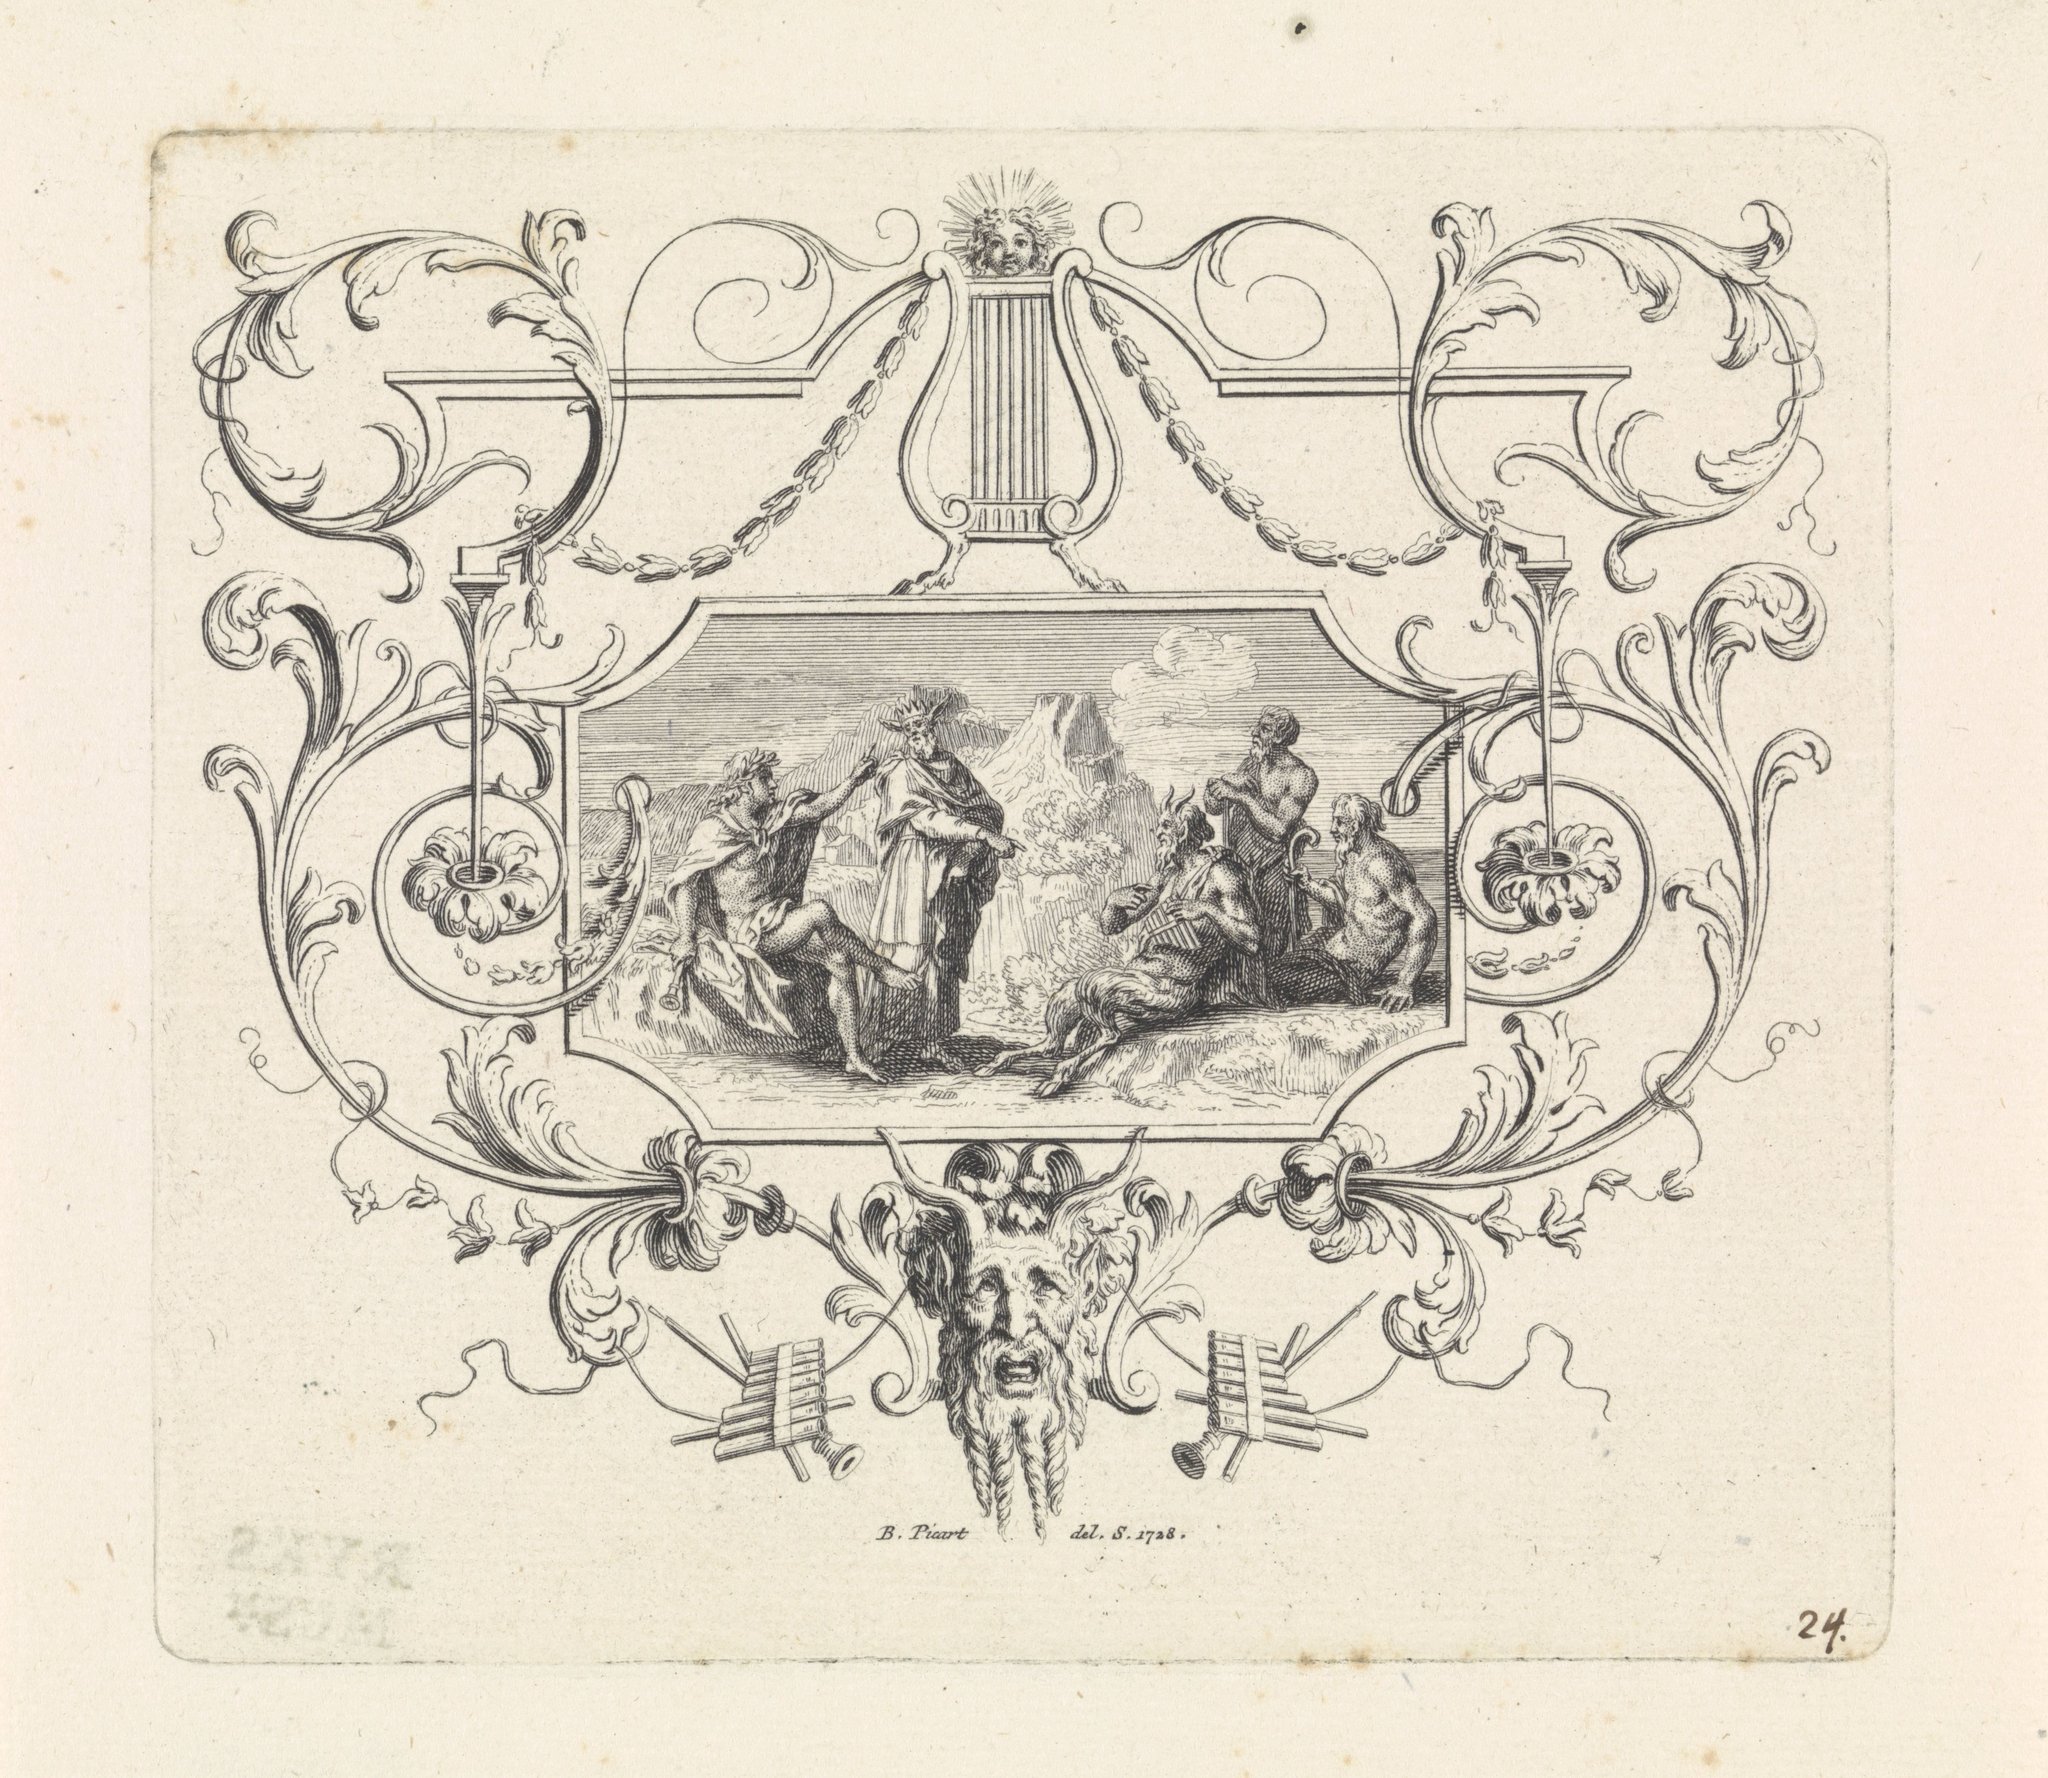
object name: print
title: Oordeel van Midas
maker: bernard picart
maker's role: draughtsman, print maker, publisher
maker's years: 1673-1733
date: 1728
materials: paper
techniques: engraving, etching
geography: amsterdam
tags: ornaments ~ art, contest between apollo and pan with the mountain god tmolus as judge, i.e. judgement of midas; midas often represented with ass's ears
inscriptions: collector's mark: Lugt 2165, number: ‘24.’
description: Prent mogelijk gebruikt in: Boileau-Despréaux, Nicolas. Oeuvres. Amsterdam: François Changuion, Den Haag, Pieter de Hondt, 1729. Nummer 24 in: Explication des Vignettes de la Seconde Edition des Oeuvres de Boileau. Amsterdam: Bernard Picart, 1729.